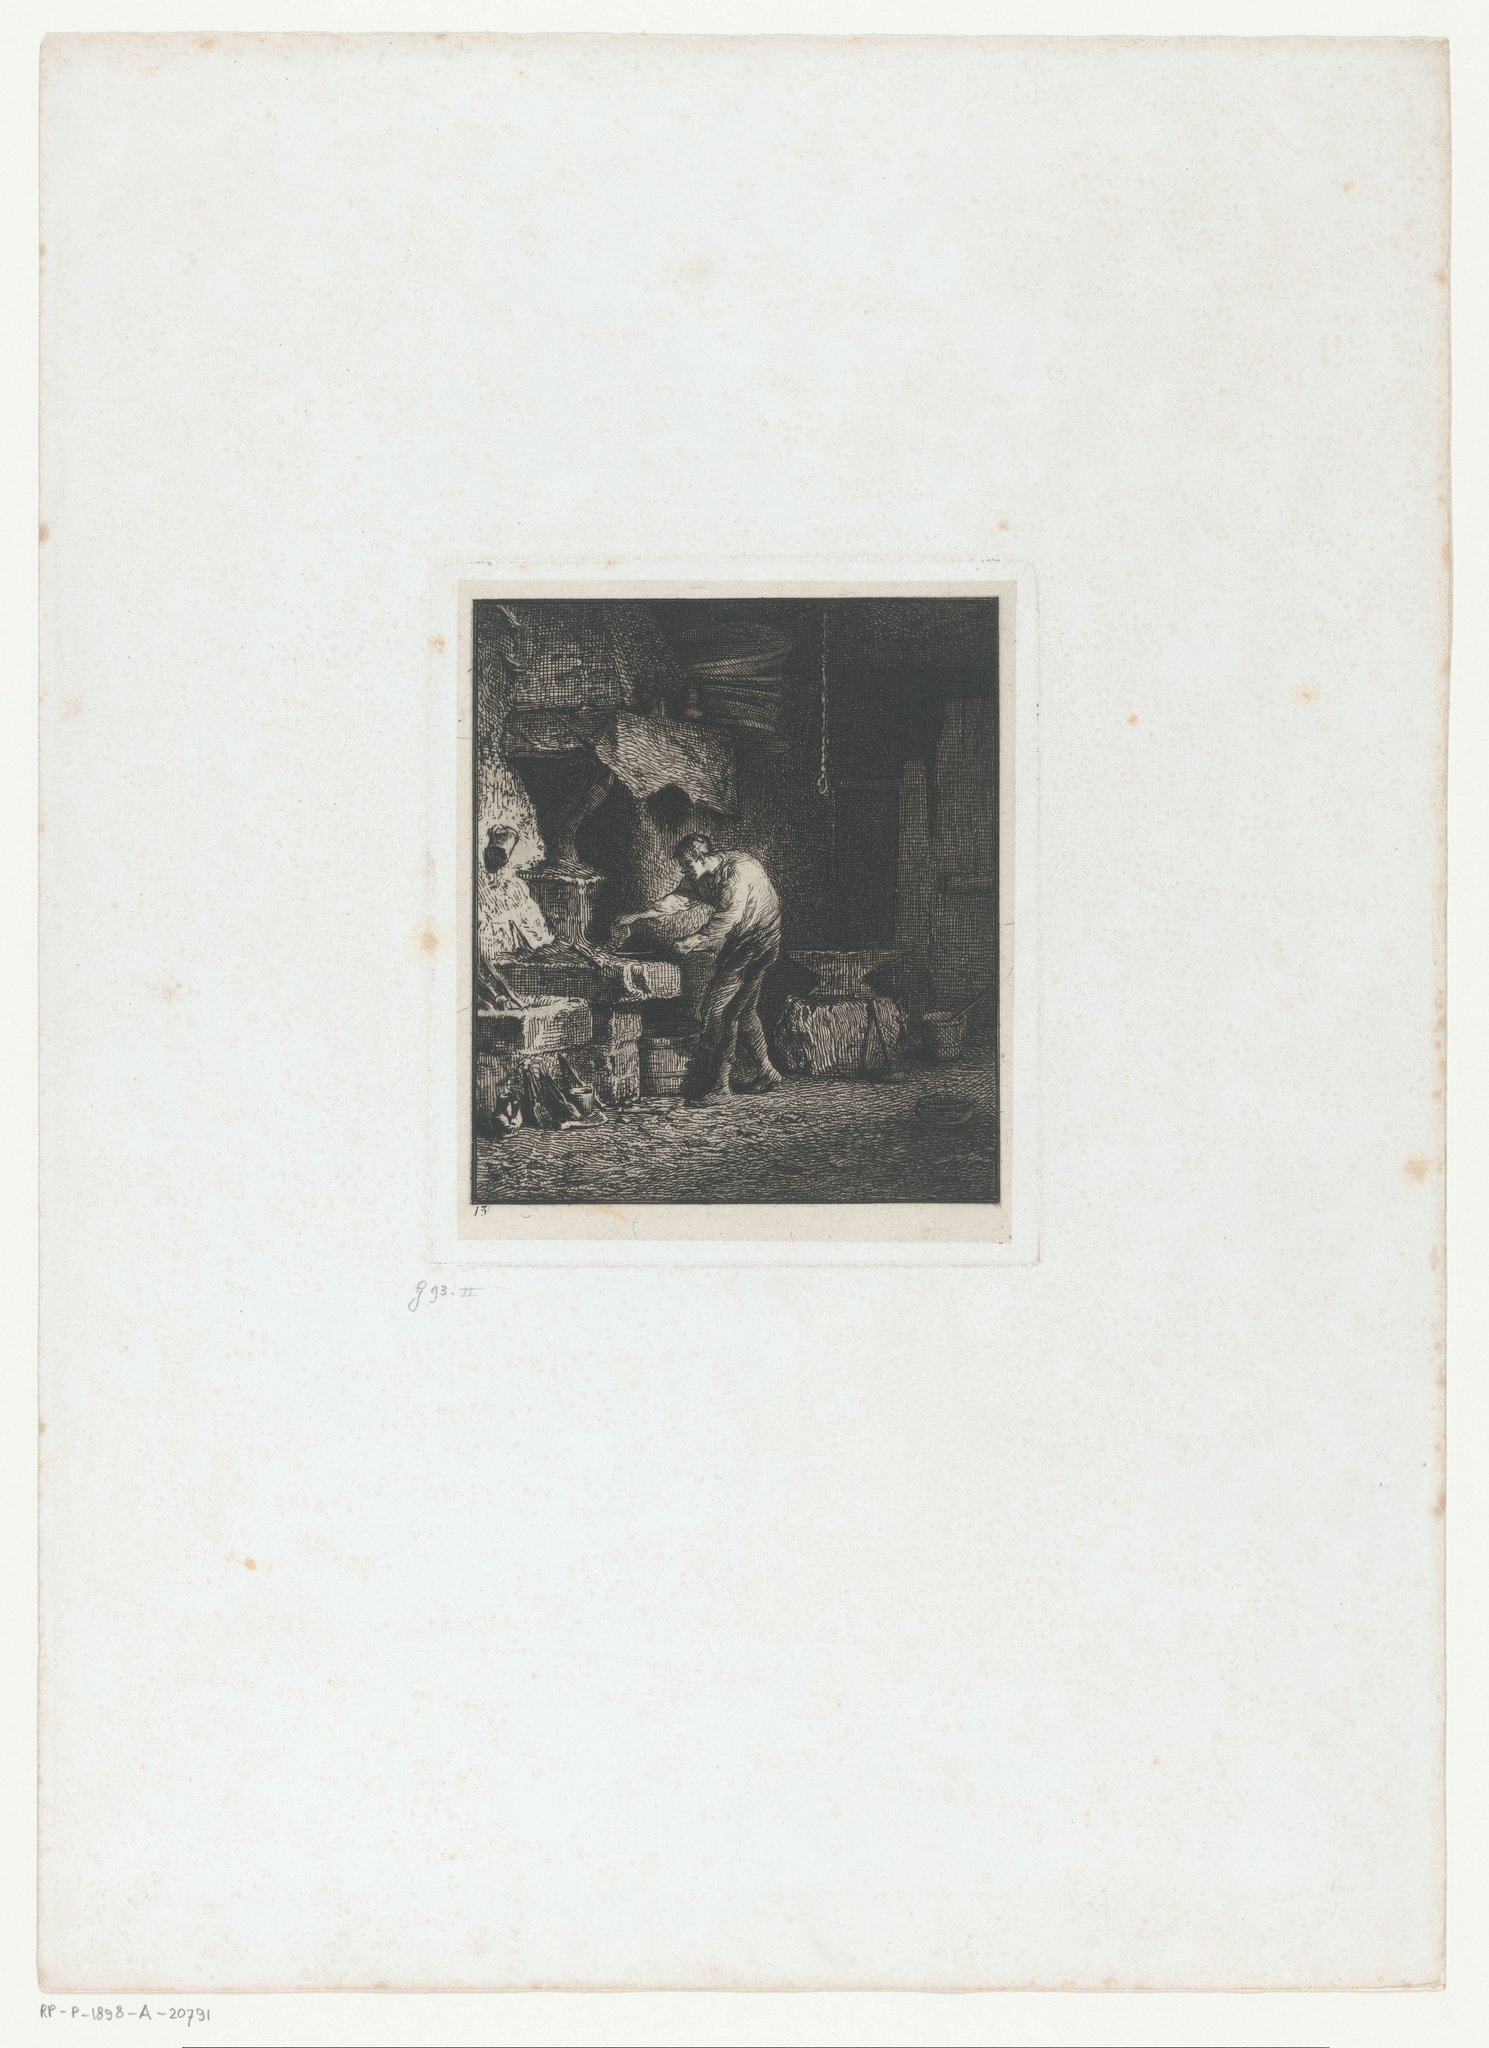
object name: print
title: 20 sujets composés et gravés à l'eau-forte par Ch. Jacque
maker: charles emile jacque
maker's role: draughtsman, painter, print maker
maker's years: 1813-1894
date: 1850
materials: paper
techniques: engraving, etching, roulette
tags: smith, blacksmith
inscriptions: collector's mark: Lugt 964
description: Maakt deel uit van een twintigdelige serie met verschillende onderwerpen door Jacque.